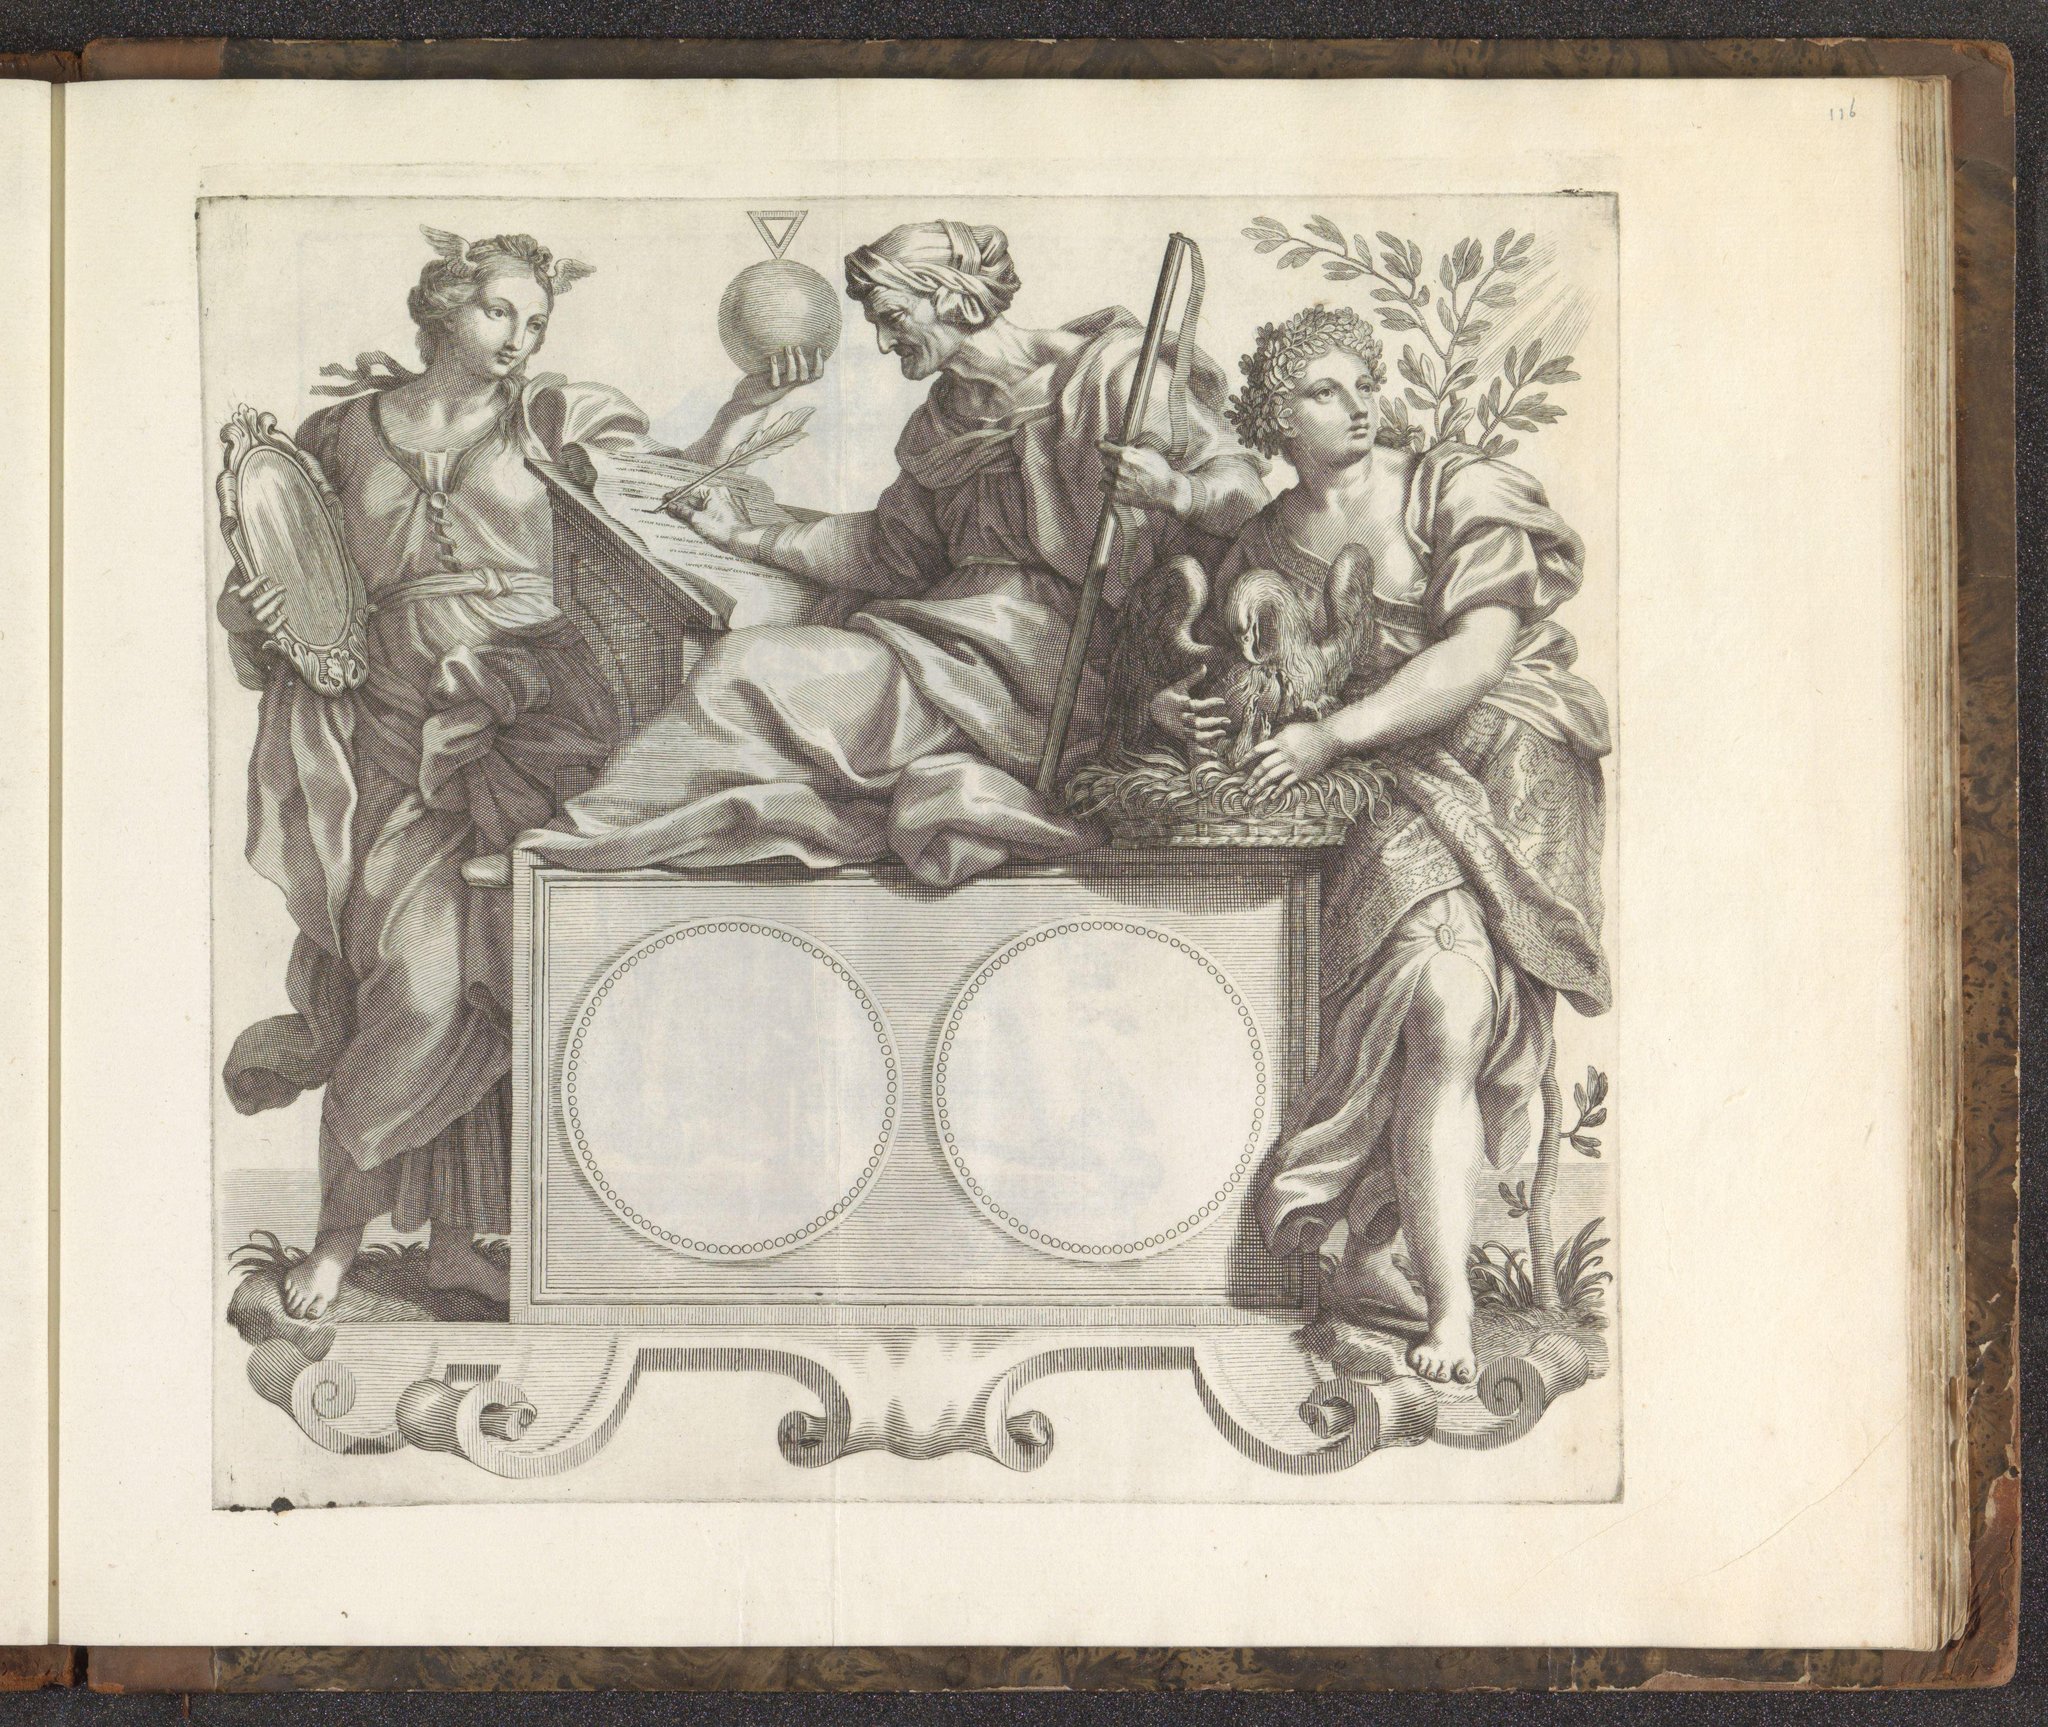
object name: album leaf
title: Numismata virorum illustrium ex Barbadica gente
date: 1673-1743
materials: paper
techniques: engraving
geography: rome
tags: symbolic representations, allegories and emblems ~ science, 'scientia'; 'scienza', 'studio' (ripa), mirror, reform; 'riforma' (ripa), goodness; 'bontà' (ripa), medal (considered as a piece of sculpture, regardless of its specific function), old woman, instruments of torture, execution or punishment: scourge, writing and letters, water-birds: pelican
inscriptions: collector's mark: Lugt 2228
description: Voetstuk in de vorm van een cartouche. Daarop een medaillon met blanco voor- en achterzijde. Het voetstuk wordt omgeven door drie vrouwelijke personificaties. Links staat de Wetenschap met twee vleugels aan het hoofd, een spiegel en een aardbol waarop een driehoek staat. In het midden Hervorming: een oude vrouw met in haar linkerhand een gesel. Met haar rechterhand schrijft ze in een open boek op een lezenaar. Naast een jonge boom staat Goedheid met een krans op het hoofd en in haar armen een nest met een pelikaan en haar jongen. De prent maakt deel uit van een album.